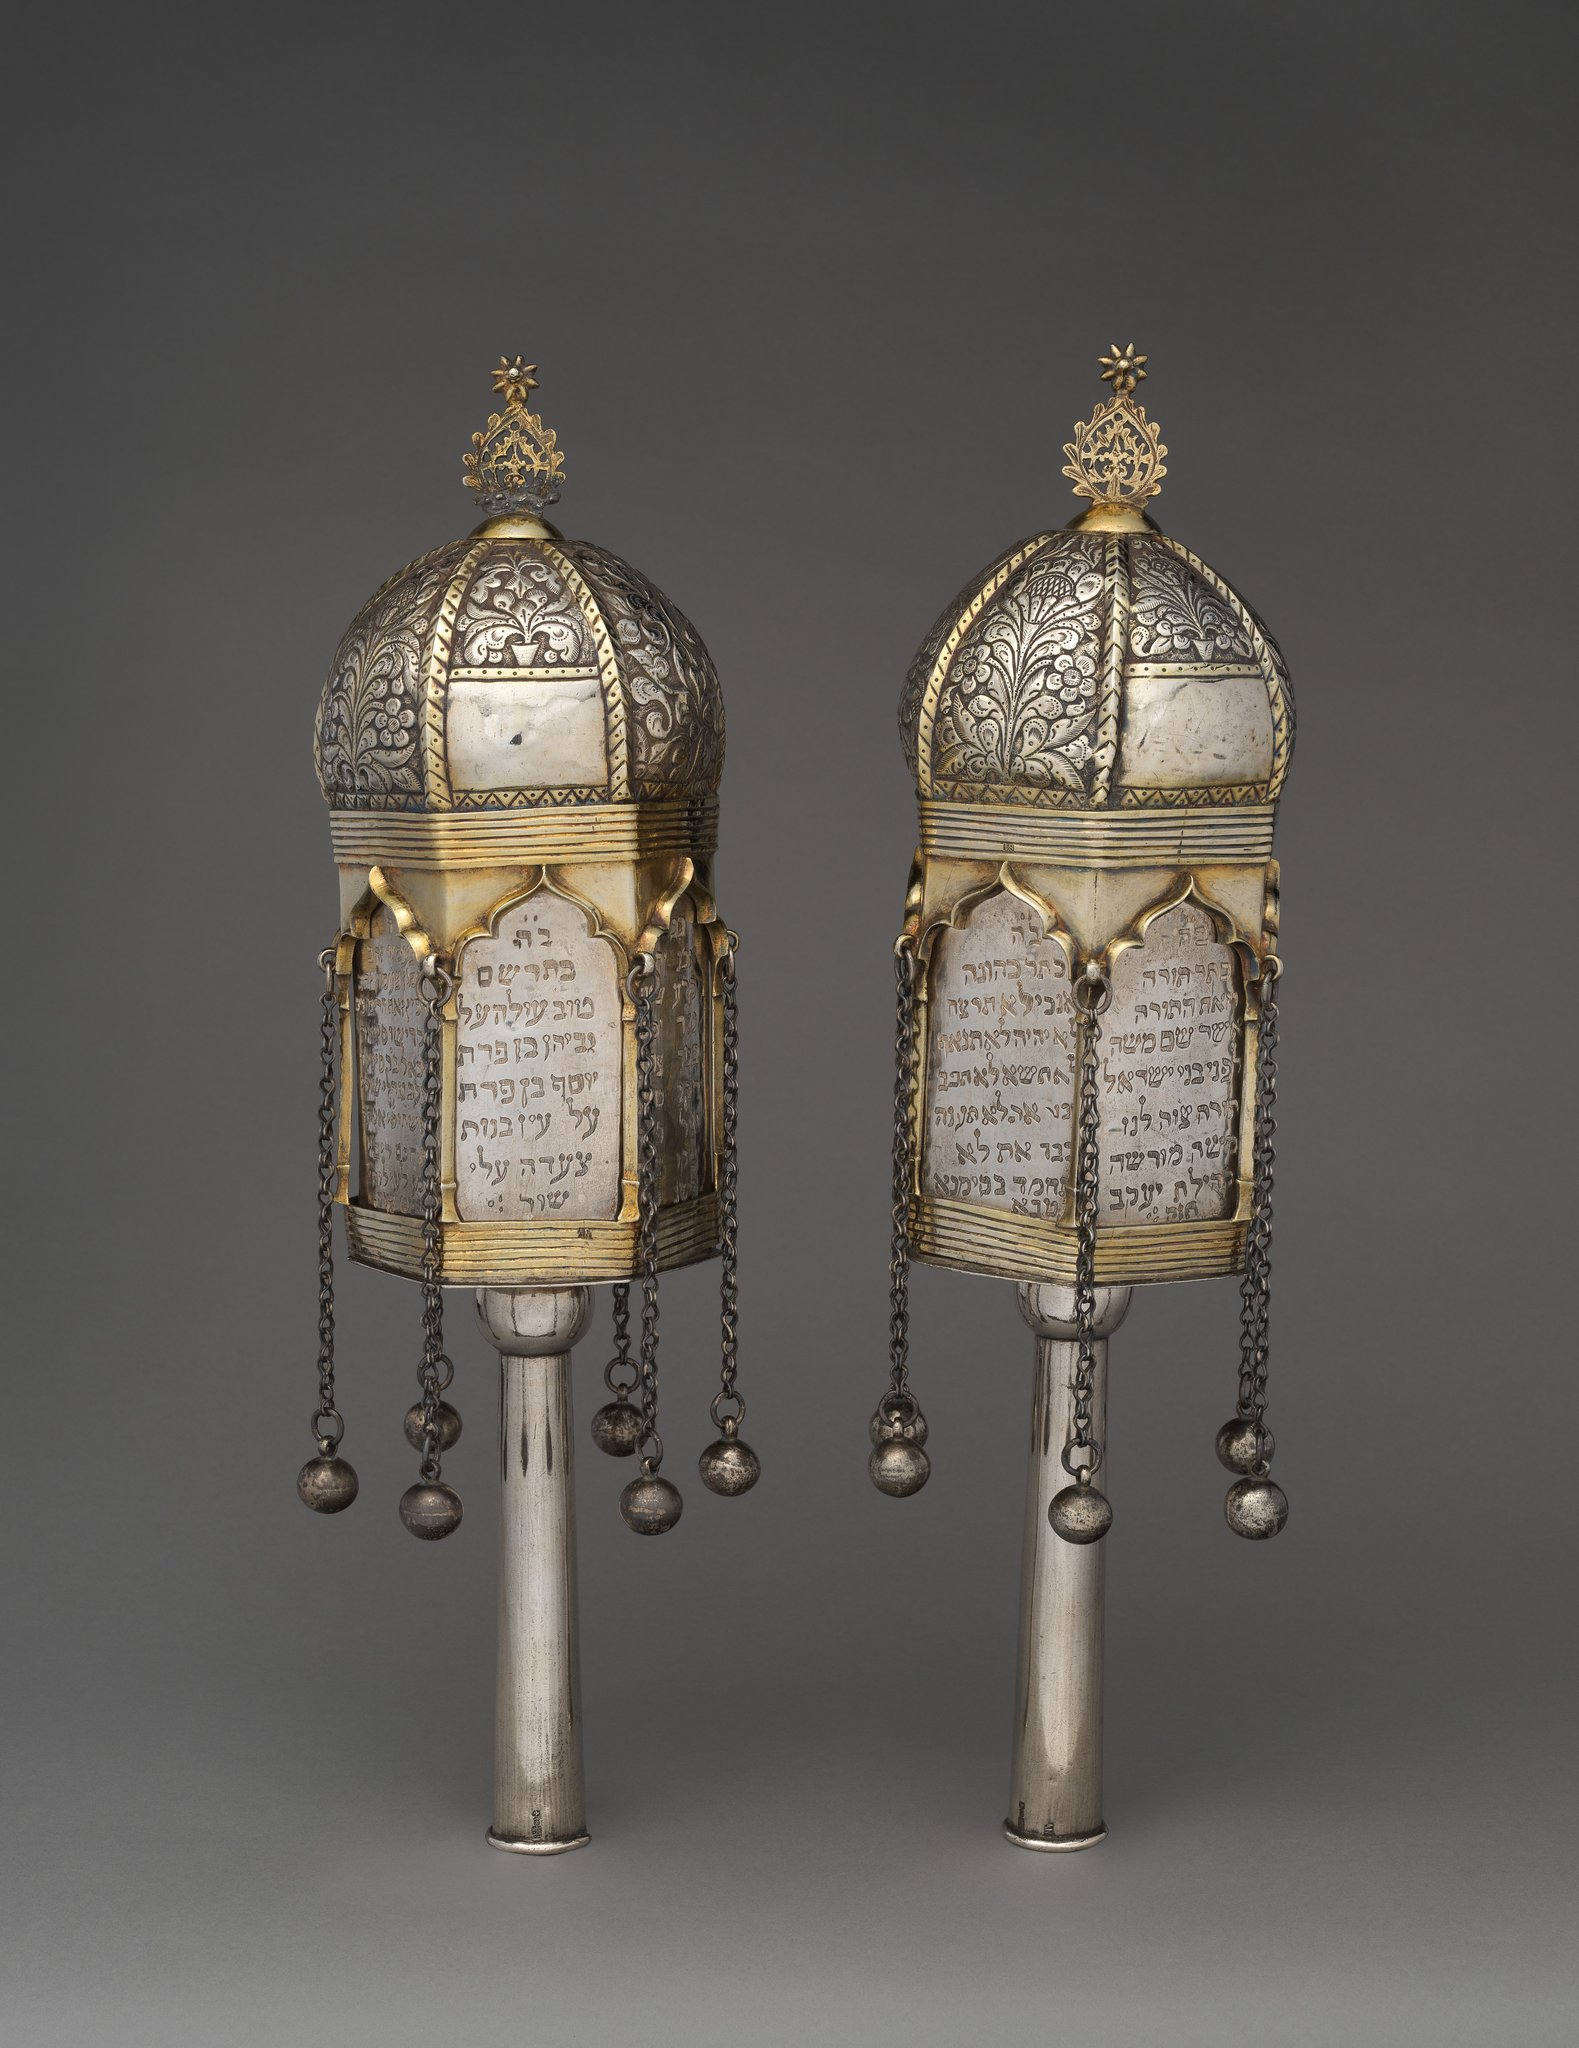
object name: torah finial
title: Pair of Torah finials (rimonim)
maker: a.m.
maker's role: maker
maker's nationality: georgian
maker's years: 1796-1896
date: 1895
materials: gilt, silver